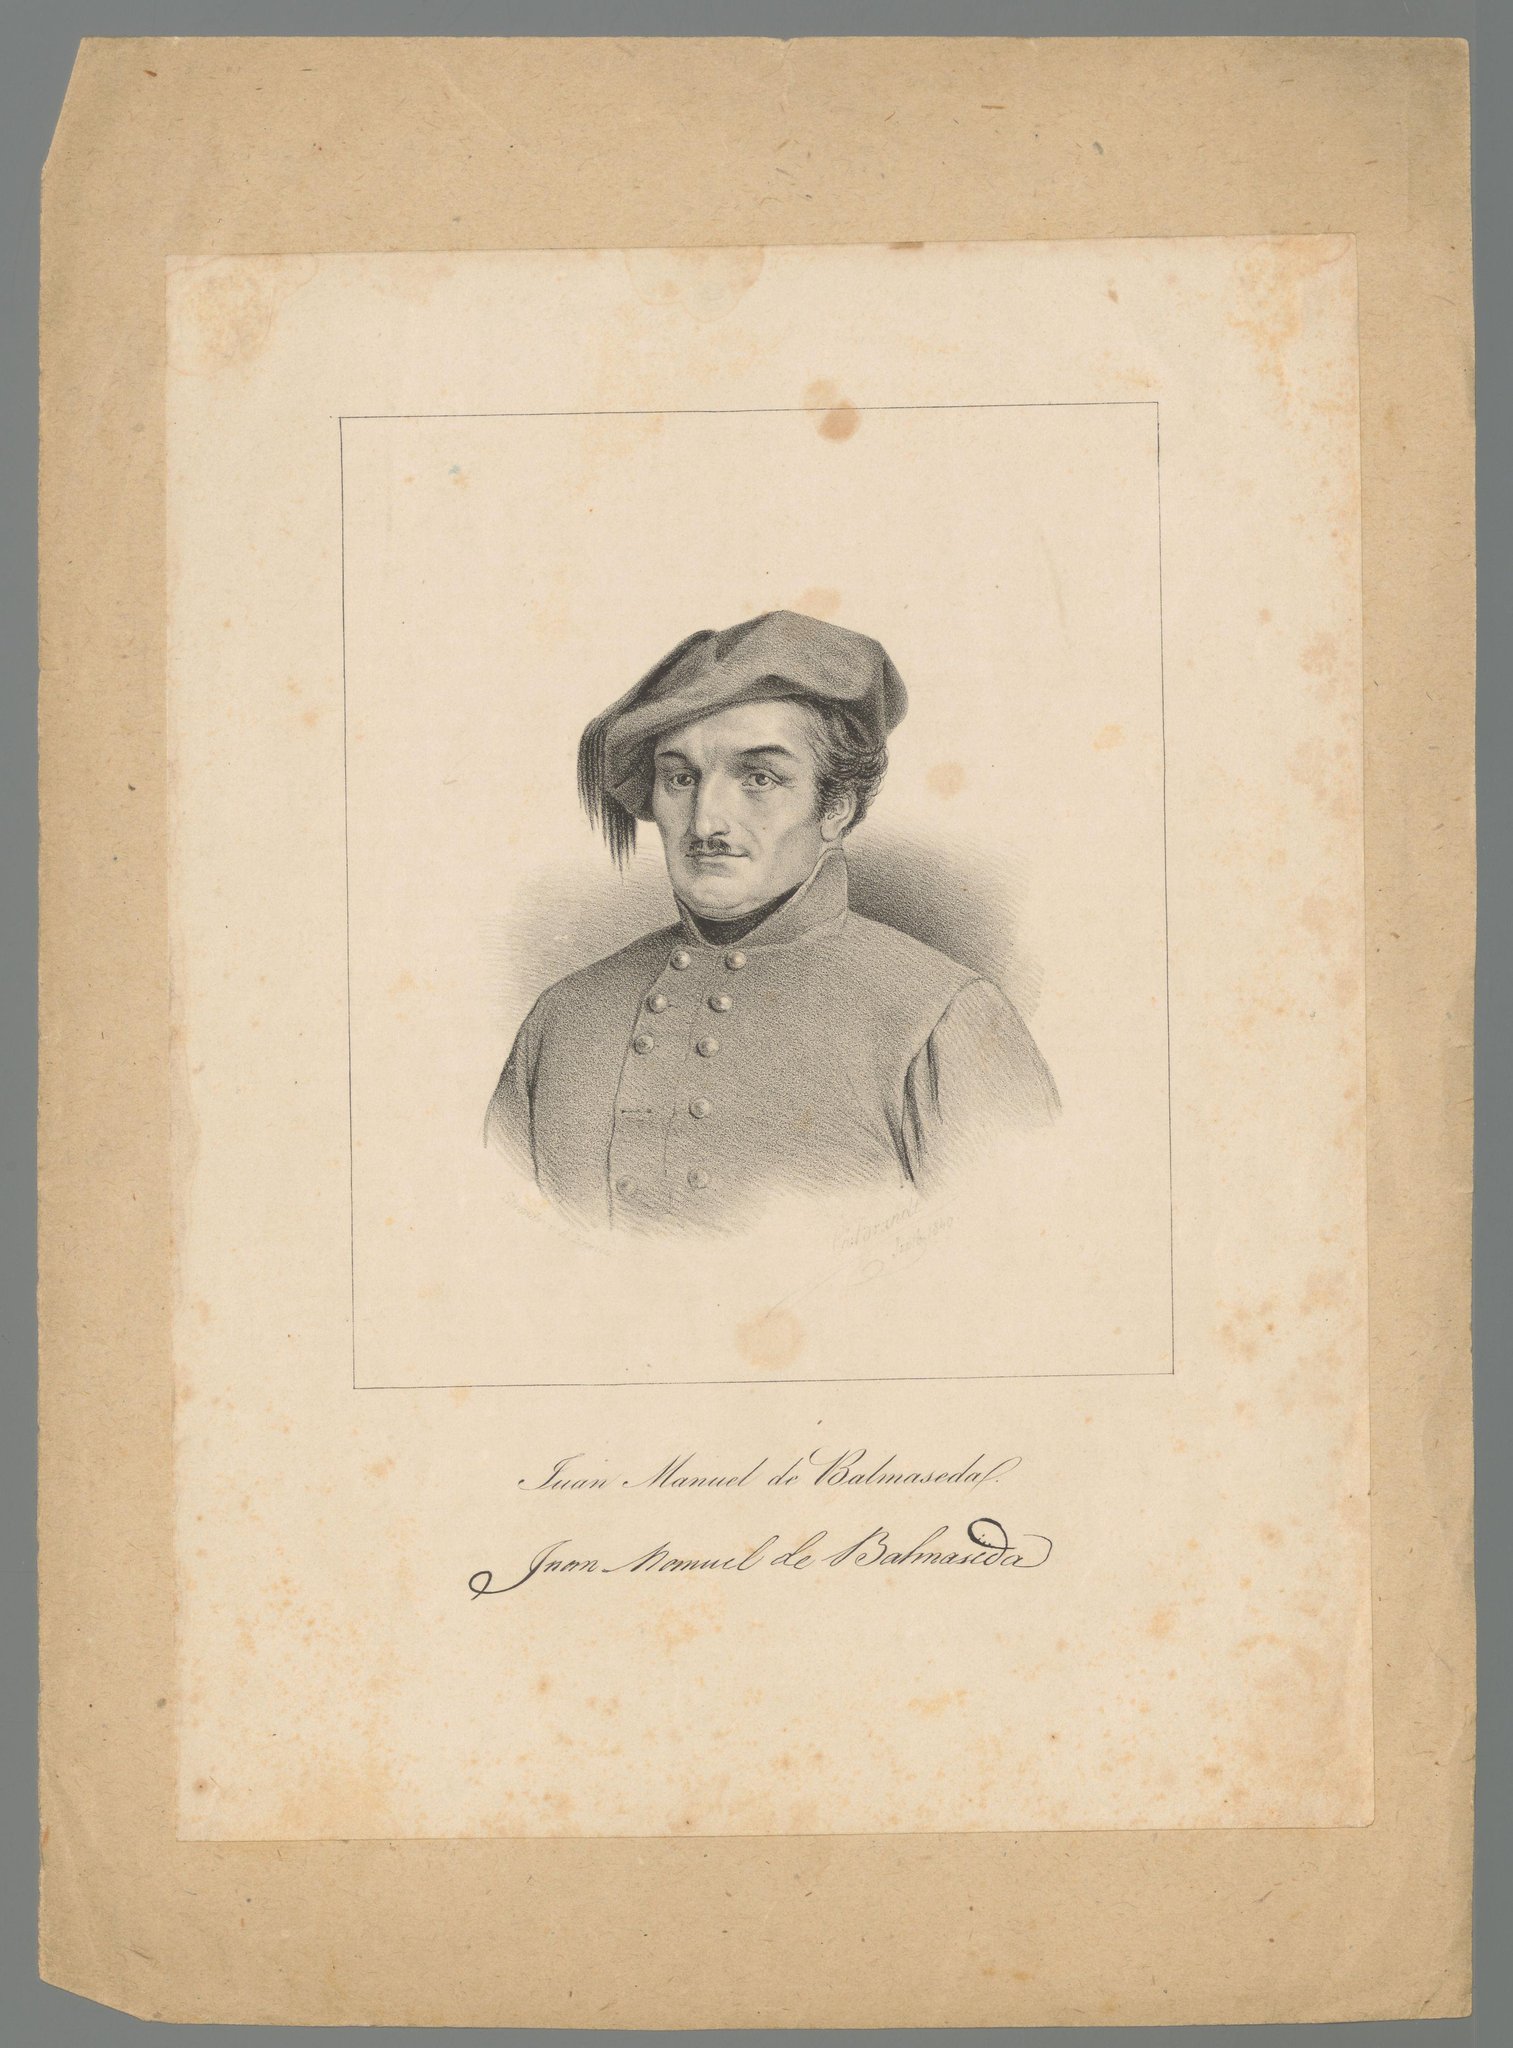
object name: print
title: Juan Manuel de Balmaseda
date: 1840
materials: paper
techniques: lithograph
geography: leipzig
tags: adult man, historical persons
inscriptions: collector's mark: Lugt 2228, collector's mark: Lugt 2760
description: Juan Manuel de Balmaseda (Fuentecén, 1800-San Petersburgo, 1846). Spaans militair. Buste naar links.